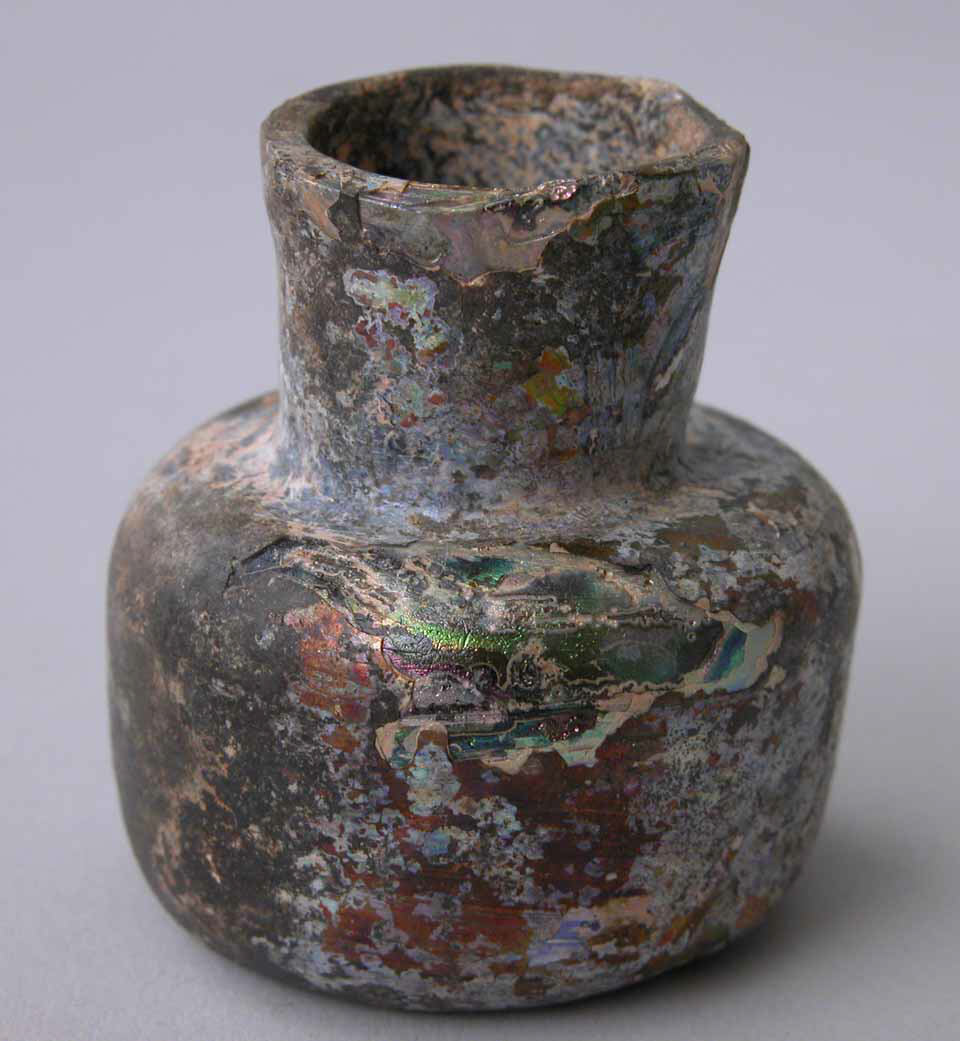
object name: inkwell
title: Two Glass Inkwells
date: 801-900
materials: glass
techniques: glassblowing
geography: iraq